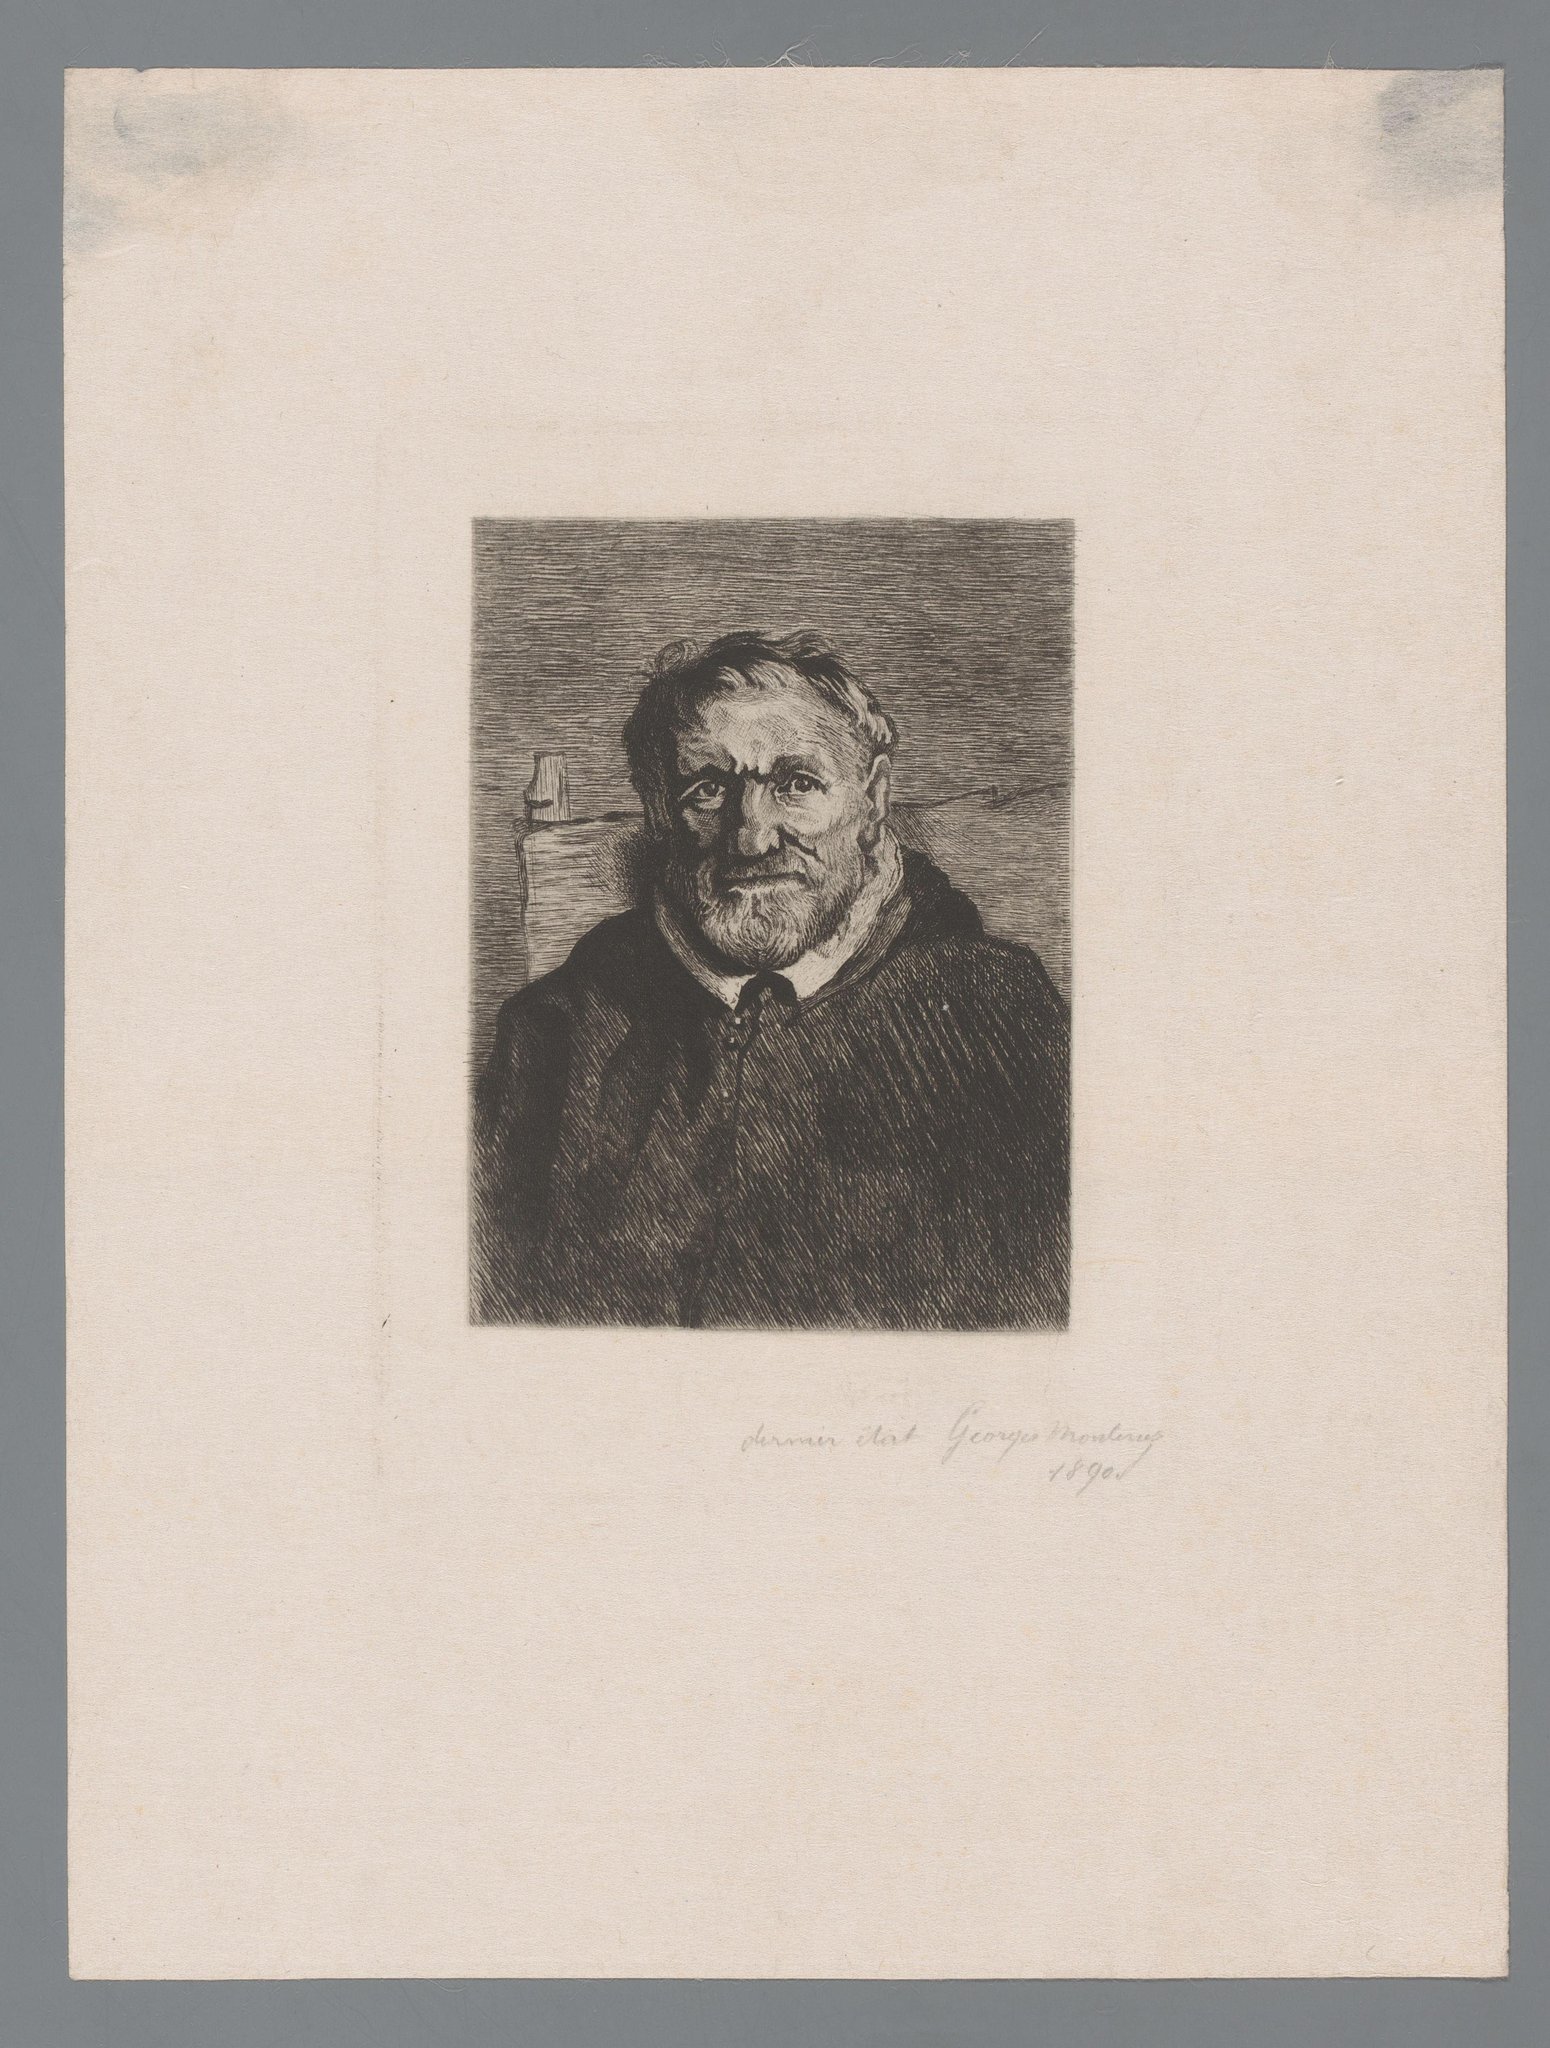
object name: print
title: Portret van een onbekende oude man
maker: georges montenez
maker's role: print maker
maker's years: 1873-1930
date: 1890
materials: paper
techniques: etching, intaglio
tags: adult man, historical persons, beard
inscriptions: inscription: ‘Dernier état Georges Montenez 1890’, collector's mark: Lugt 2228